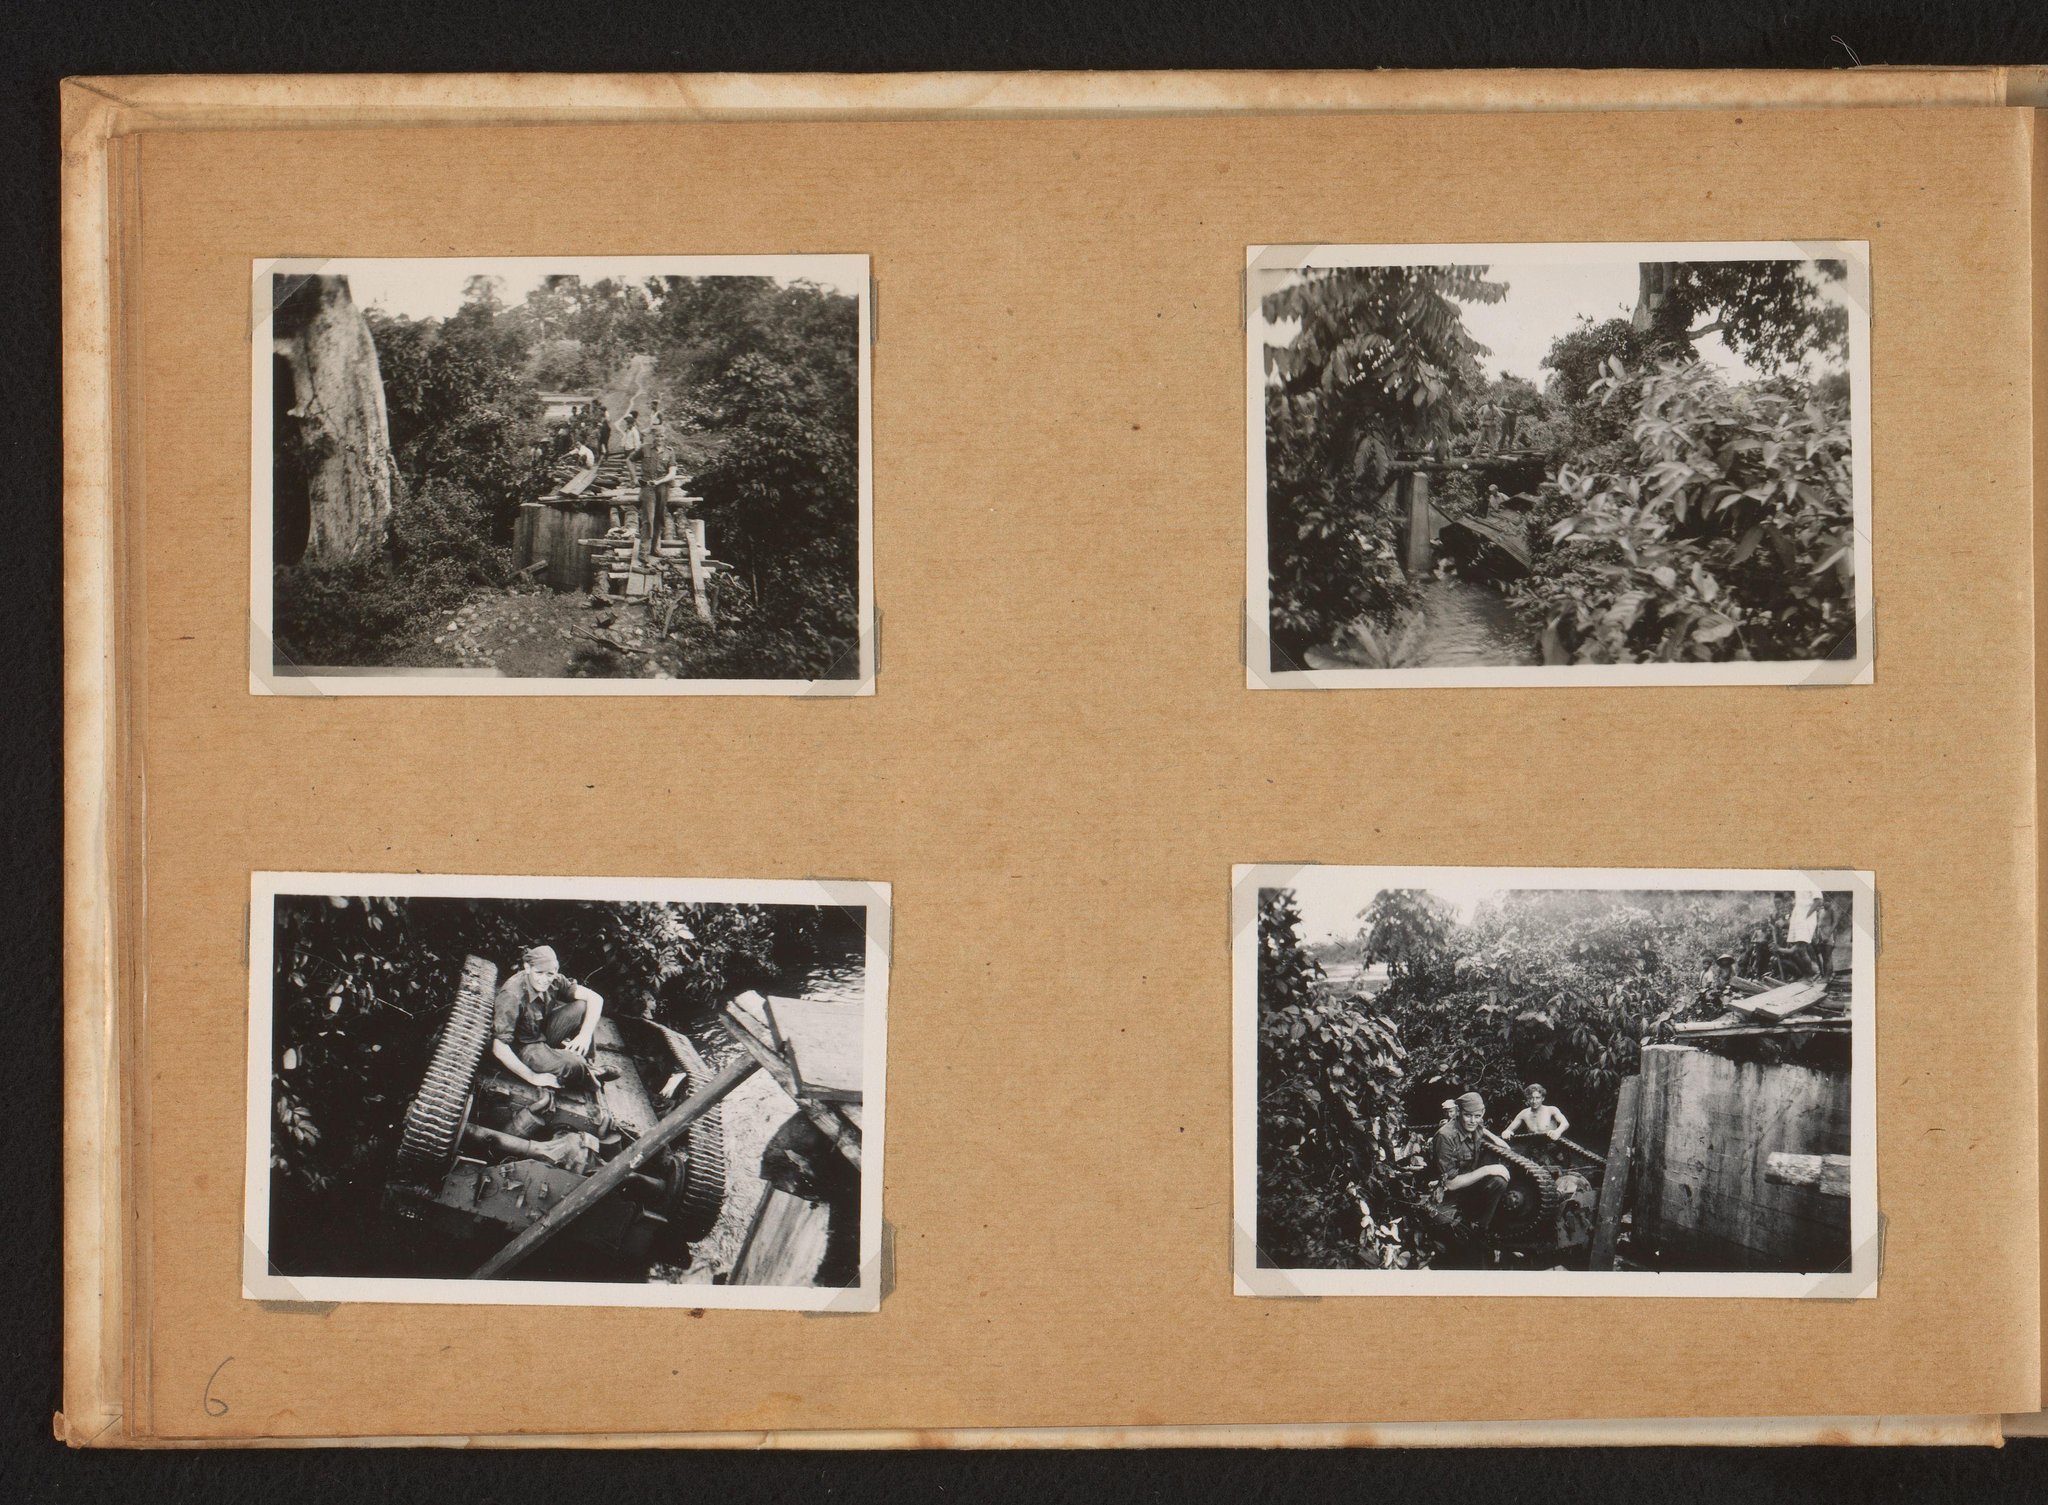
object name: photograph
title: Ongeluk met een Carrier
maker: Anonymous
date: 1948-1949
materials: paper, photographic support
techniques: gelatin silver print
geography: dutch east indies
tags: the company, the unit, the troop ~ military service, modern forms of military vehicles, dutch east indies, the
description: Albumblad met vier foto's van een ongeluk met een Bren Carrier die van een brug is gevallen. Onderdeel van het fotoalbum 'Ter herinnering aan mijn diensttijd overzee' 1948-1949.